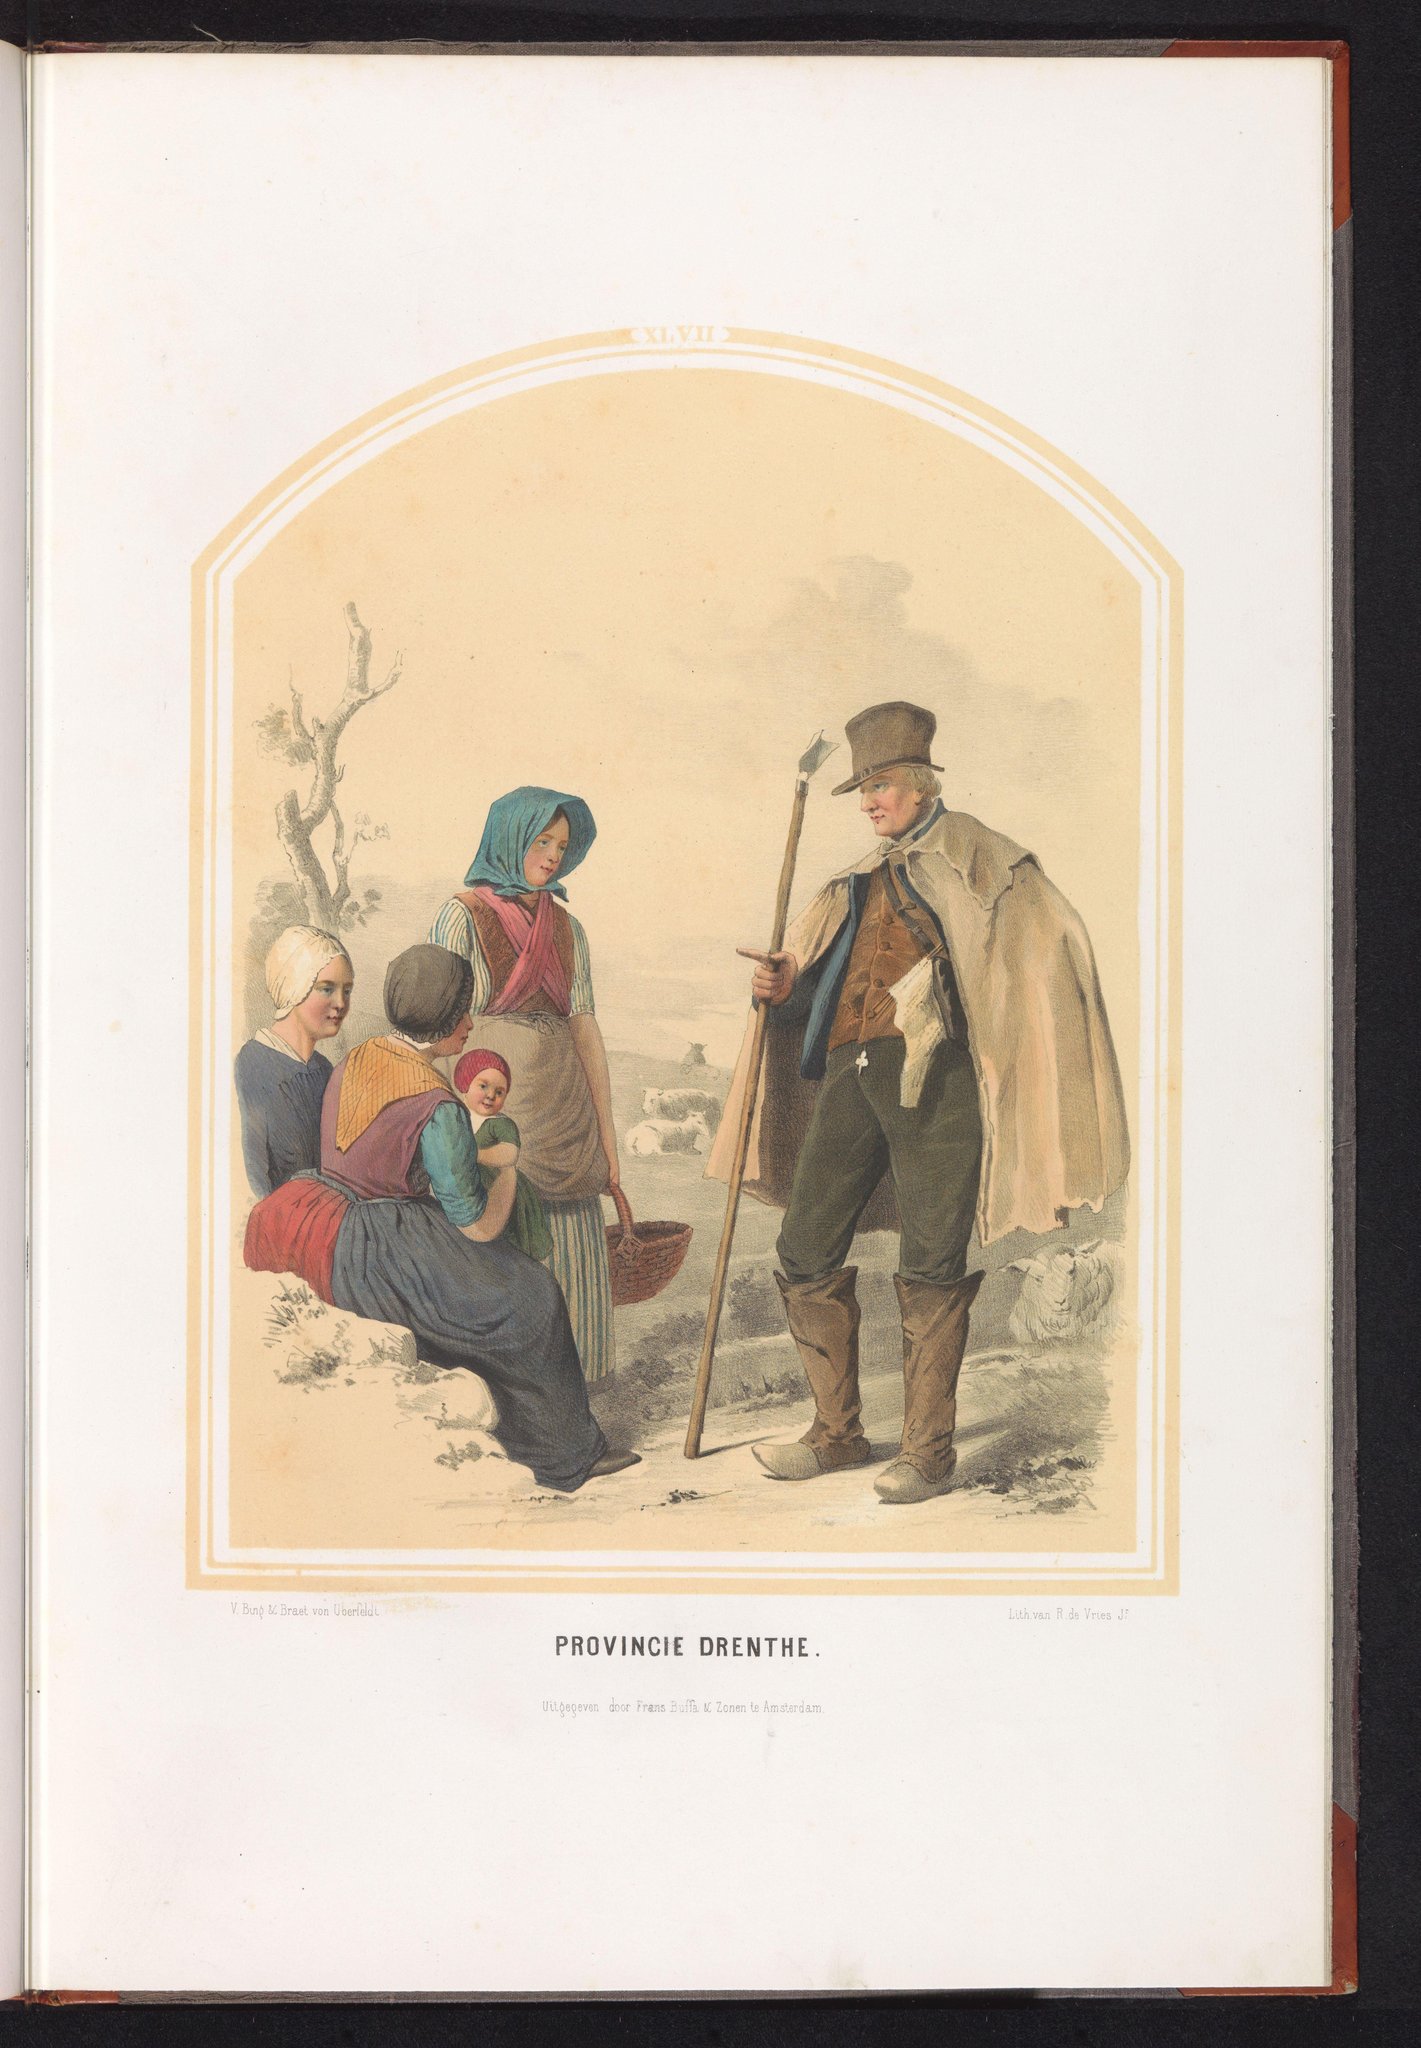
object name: costume print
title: Provincie Drenthe / XLVII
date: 1857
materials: paper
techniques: hand coloring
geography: netherlands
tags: folk costume, regional costume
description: Klederdracht in de provincie Drenthe. Man bij een groep vrouwen met een kind. Illustratie in een boek uit 1857 met 56 platen van Nederlandse klederdrachten.